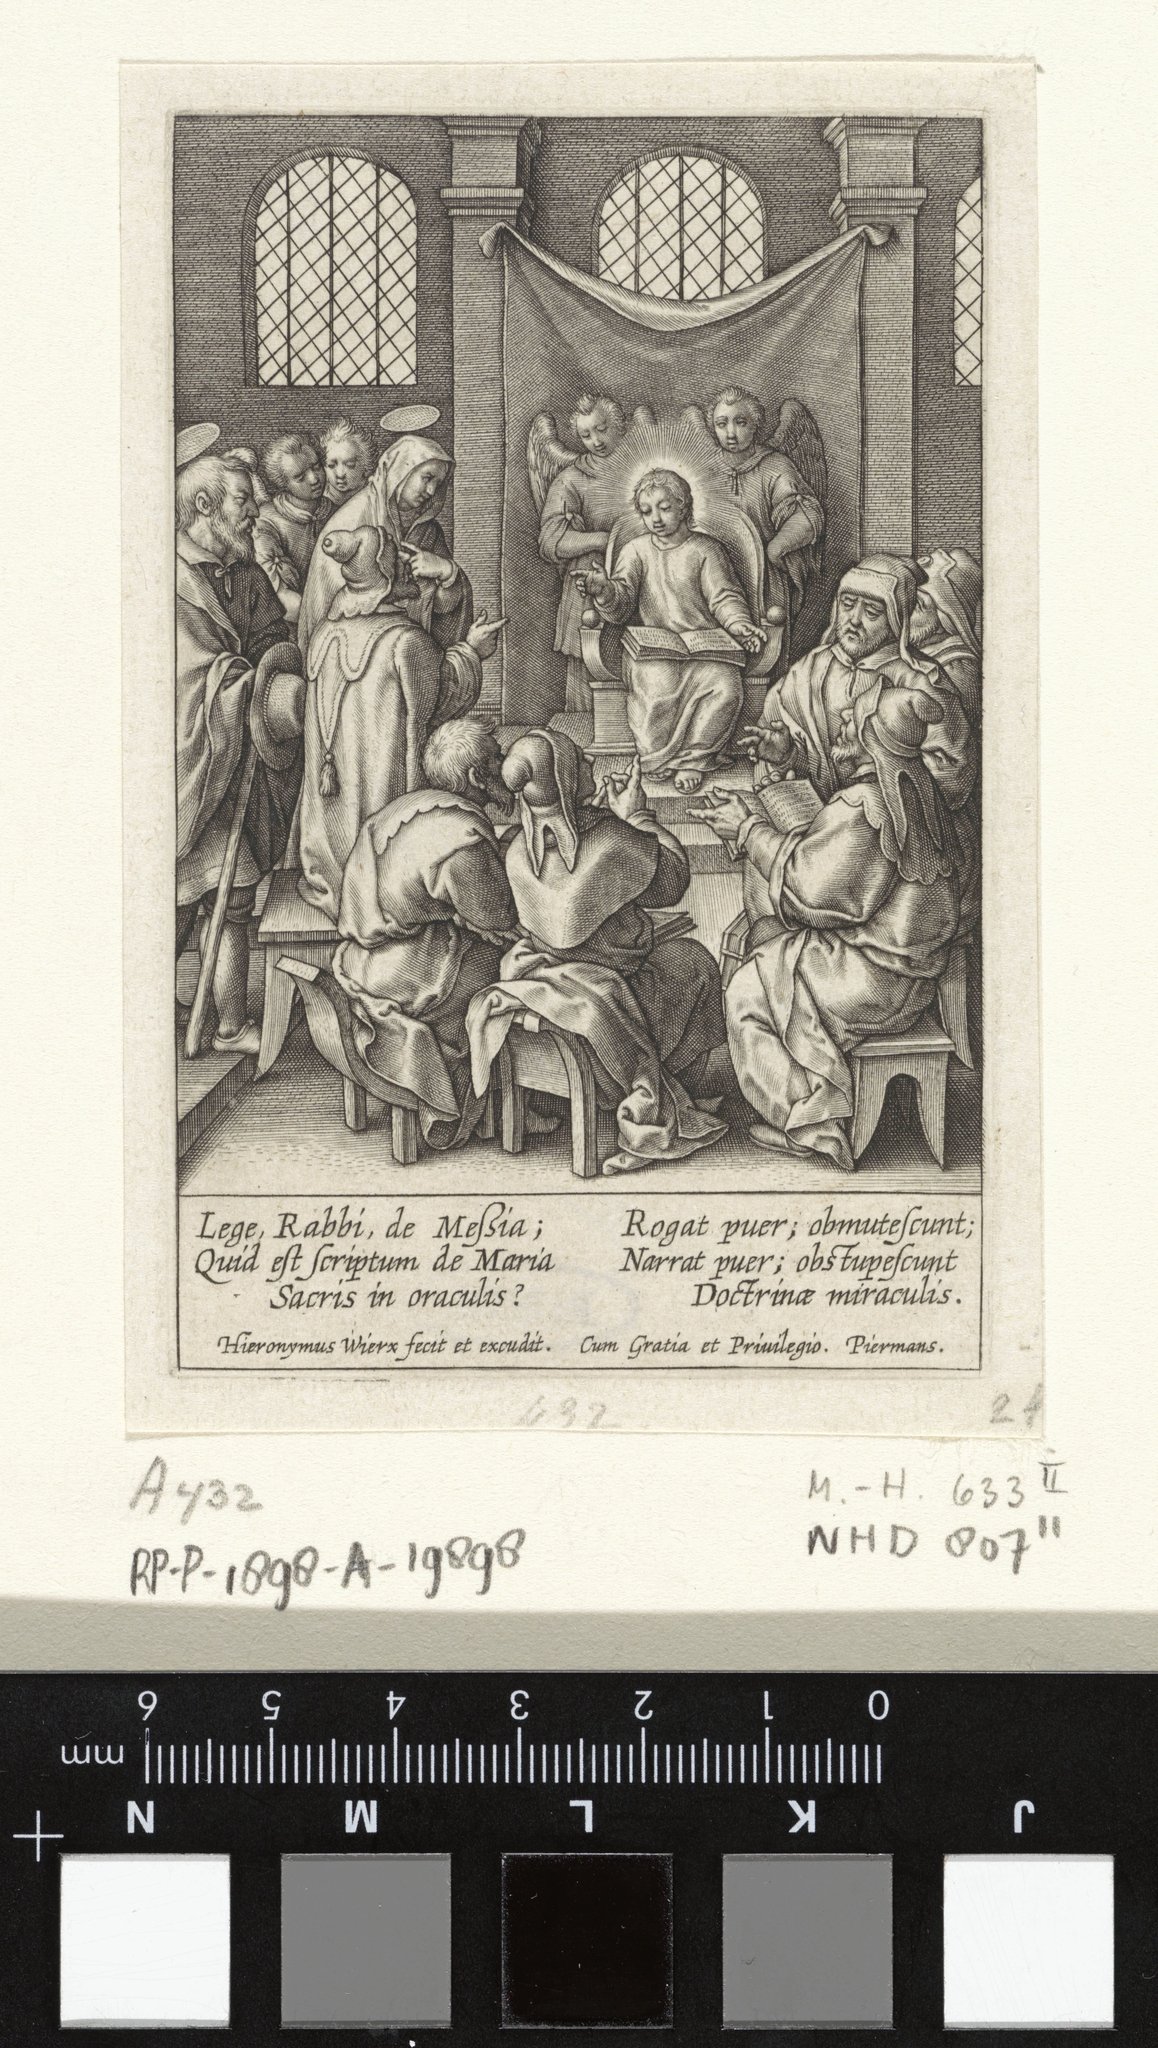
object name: print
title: Leven van de maagd Maria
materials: paper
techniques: engraving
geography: antwerp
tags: christ's dispute with the doctors in the temple; he counts his arguments on his fingers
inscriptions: collector's mark: Lugt 2228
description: Christus zit in de tempel op een troon, achter hem twee engelen. Hij legt de schrift uit aan de schriftgeleerden. Jozef en Maria lopen de tempel binnen en vinden hun twaalfjarige zoon tussen de geleerden. In de marge een zesregelig onderschrift, in twee kolommen, in het Latijn.